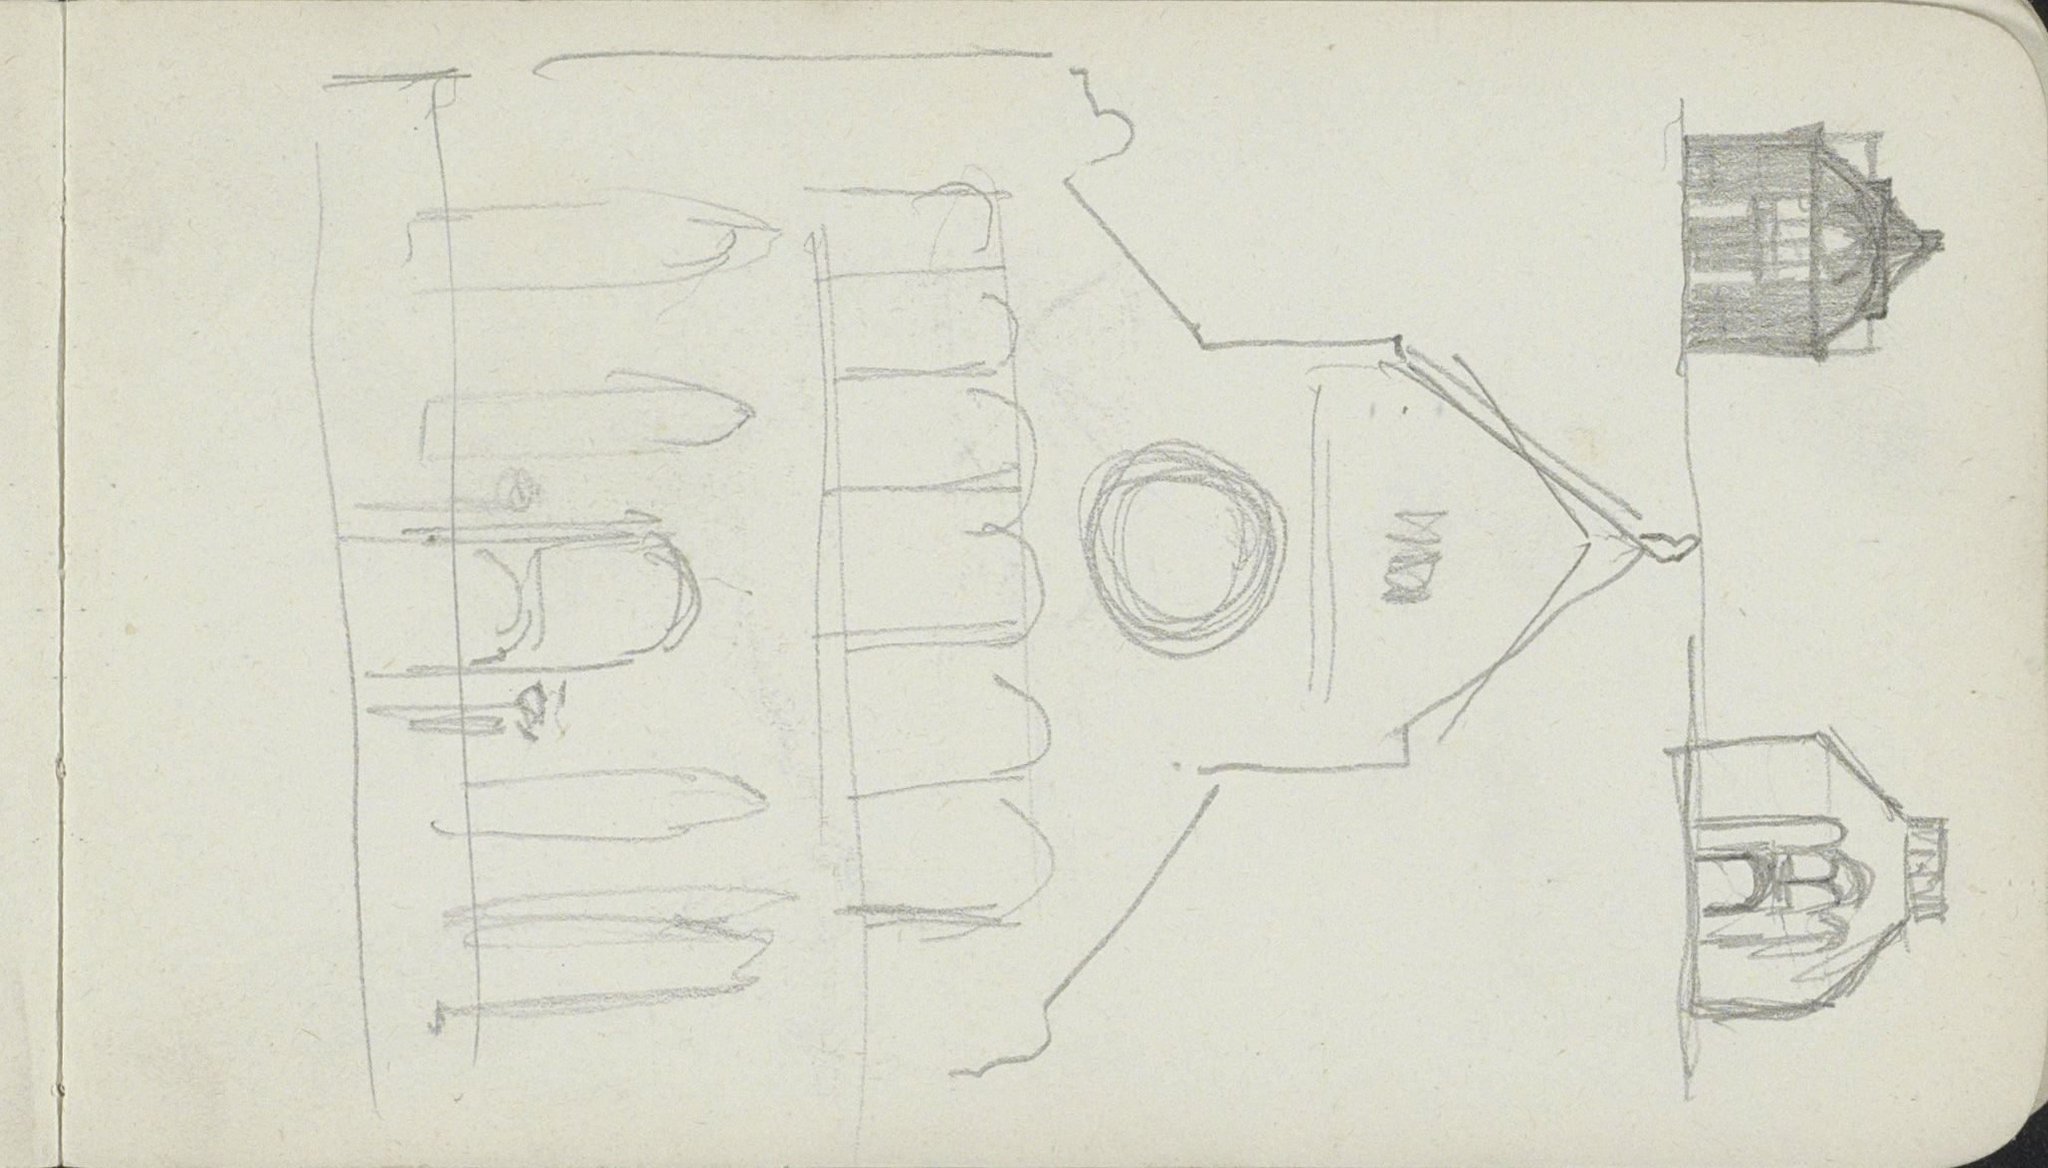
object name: sketchbook leaf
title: Drie vooraanzichten van kerken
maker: carel adolph lion cachet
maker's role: draughtsman, print maker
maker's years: 1864-1945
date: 1905-1906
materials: paper, pencil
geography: vreeland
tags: church (exterior)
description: Blad 11 recto uit een schetsboek met 34 bladen.